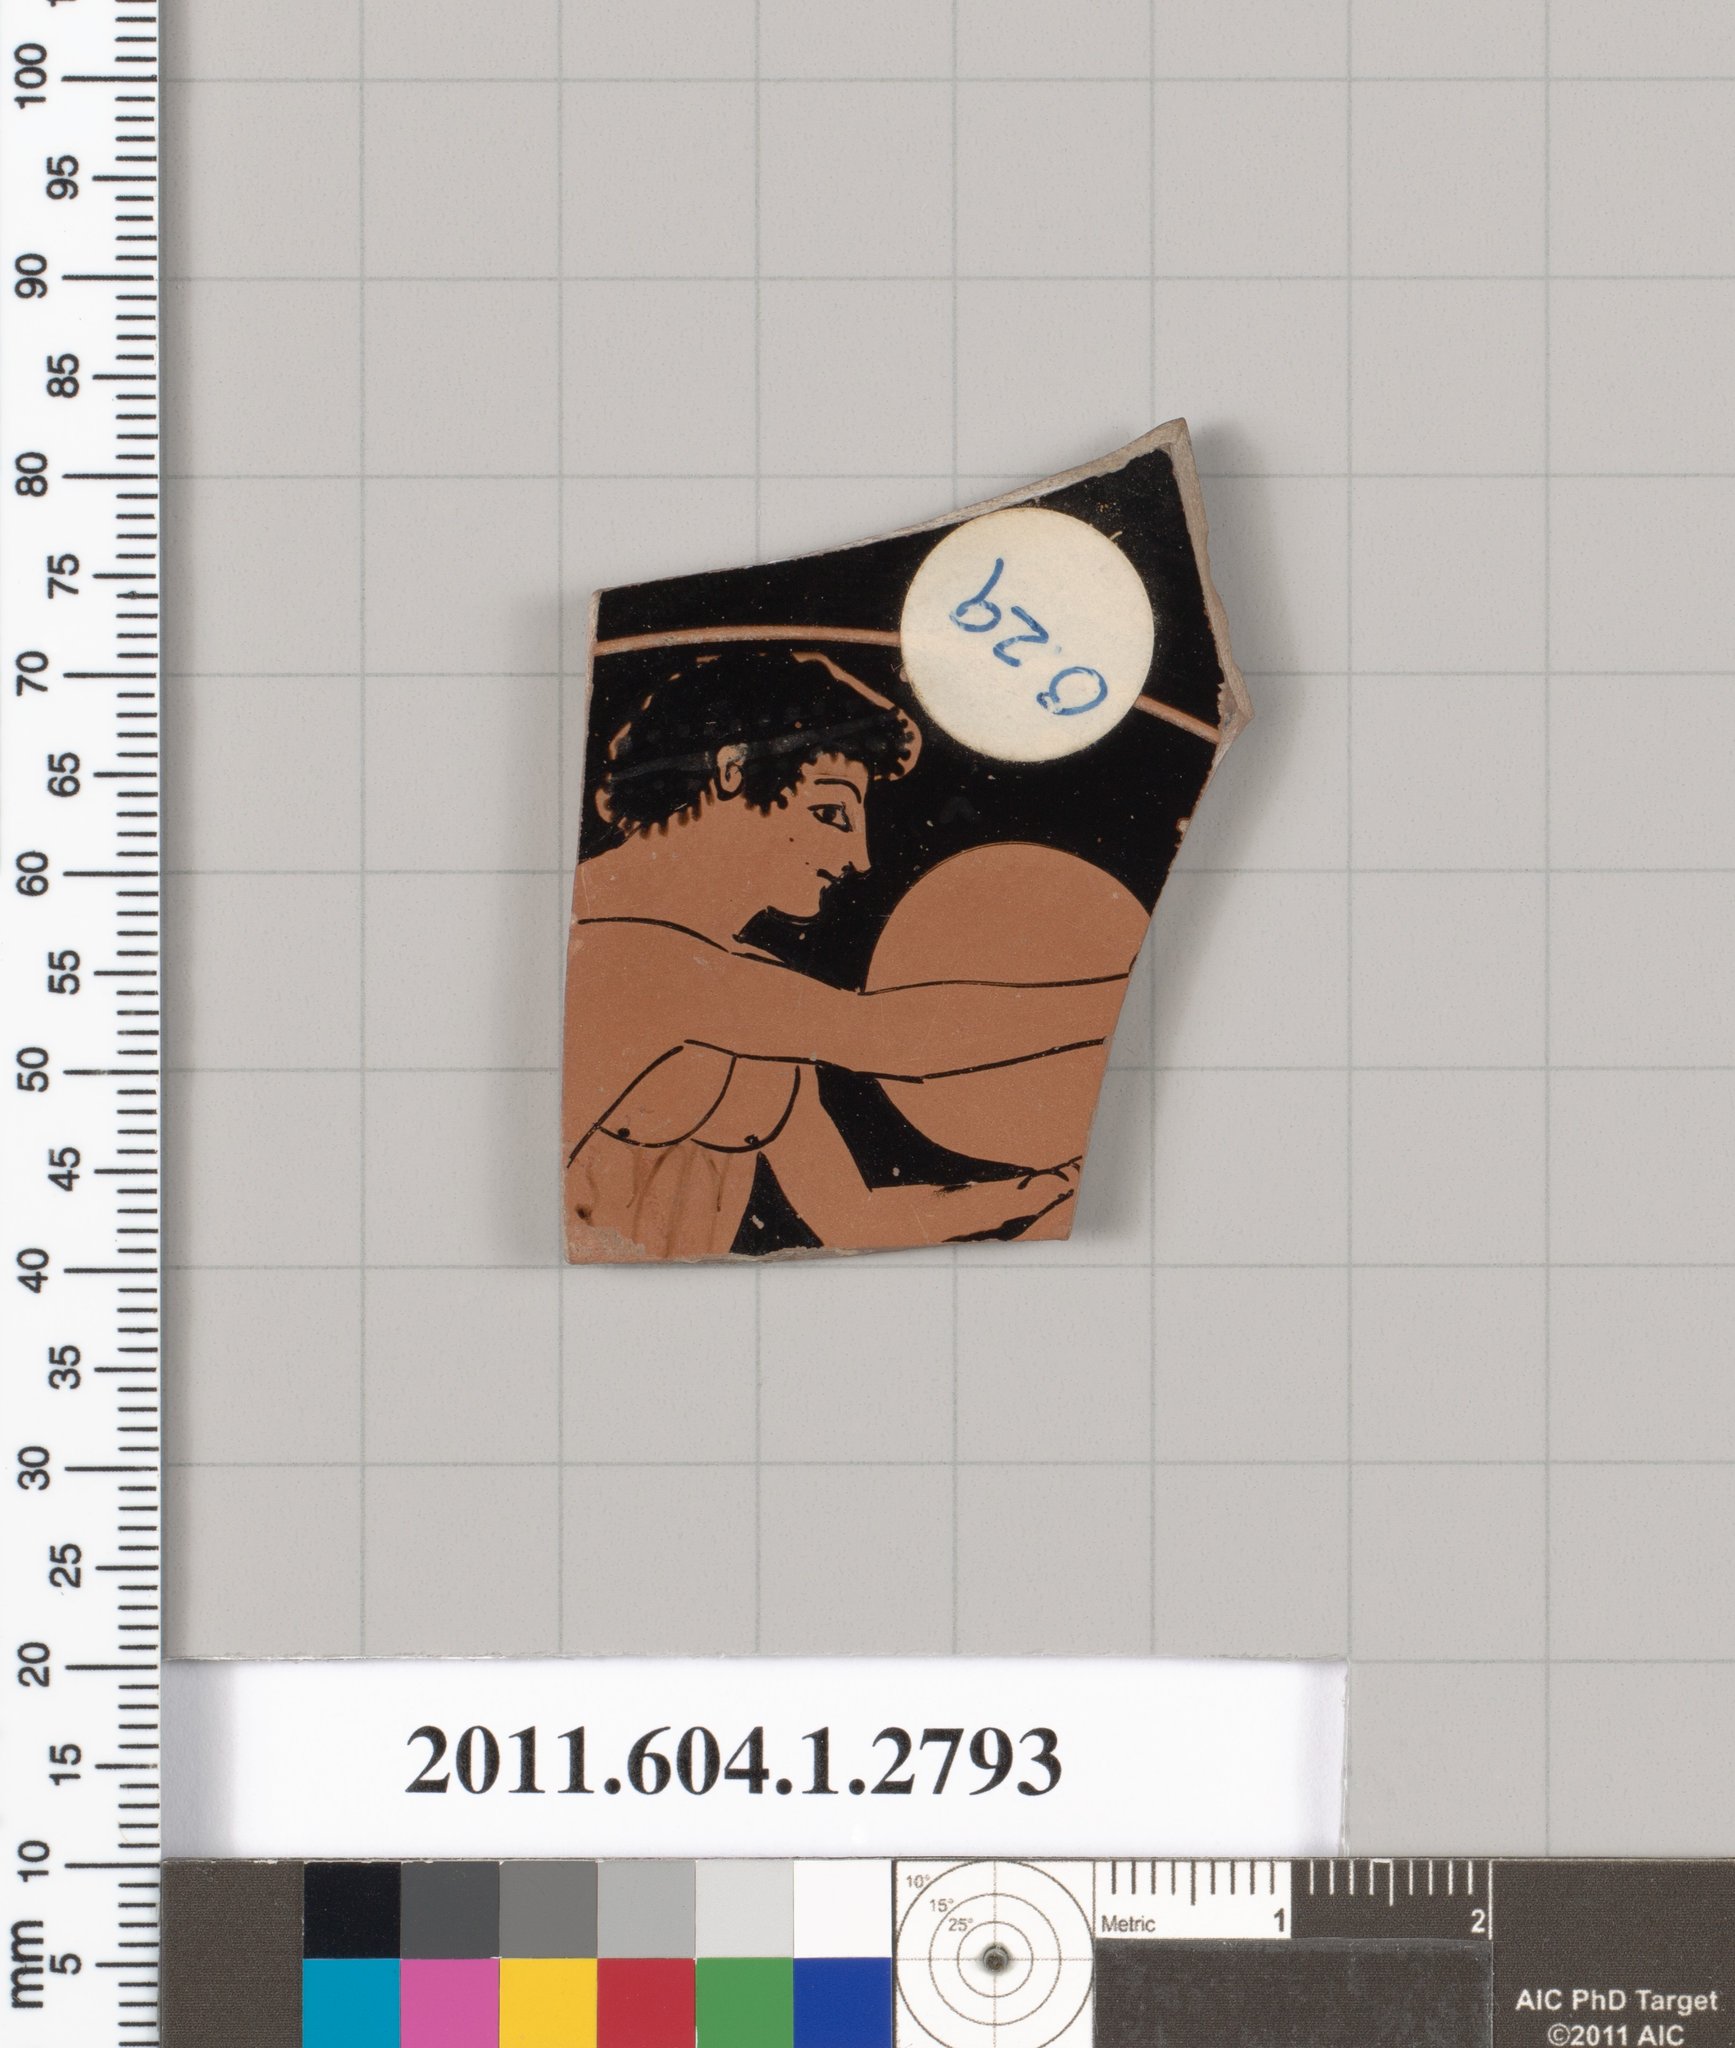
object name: kylix fragment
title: Terracotta fragment of a kylix (drinking cup)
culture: greek, attic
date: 520-500 BCE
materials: terracotta